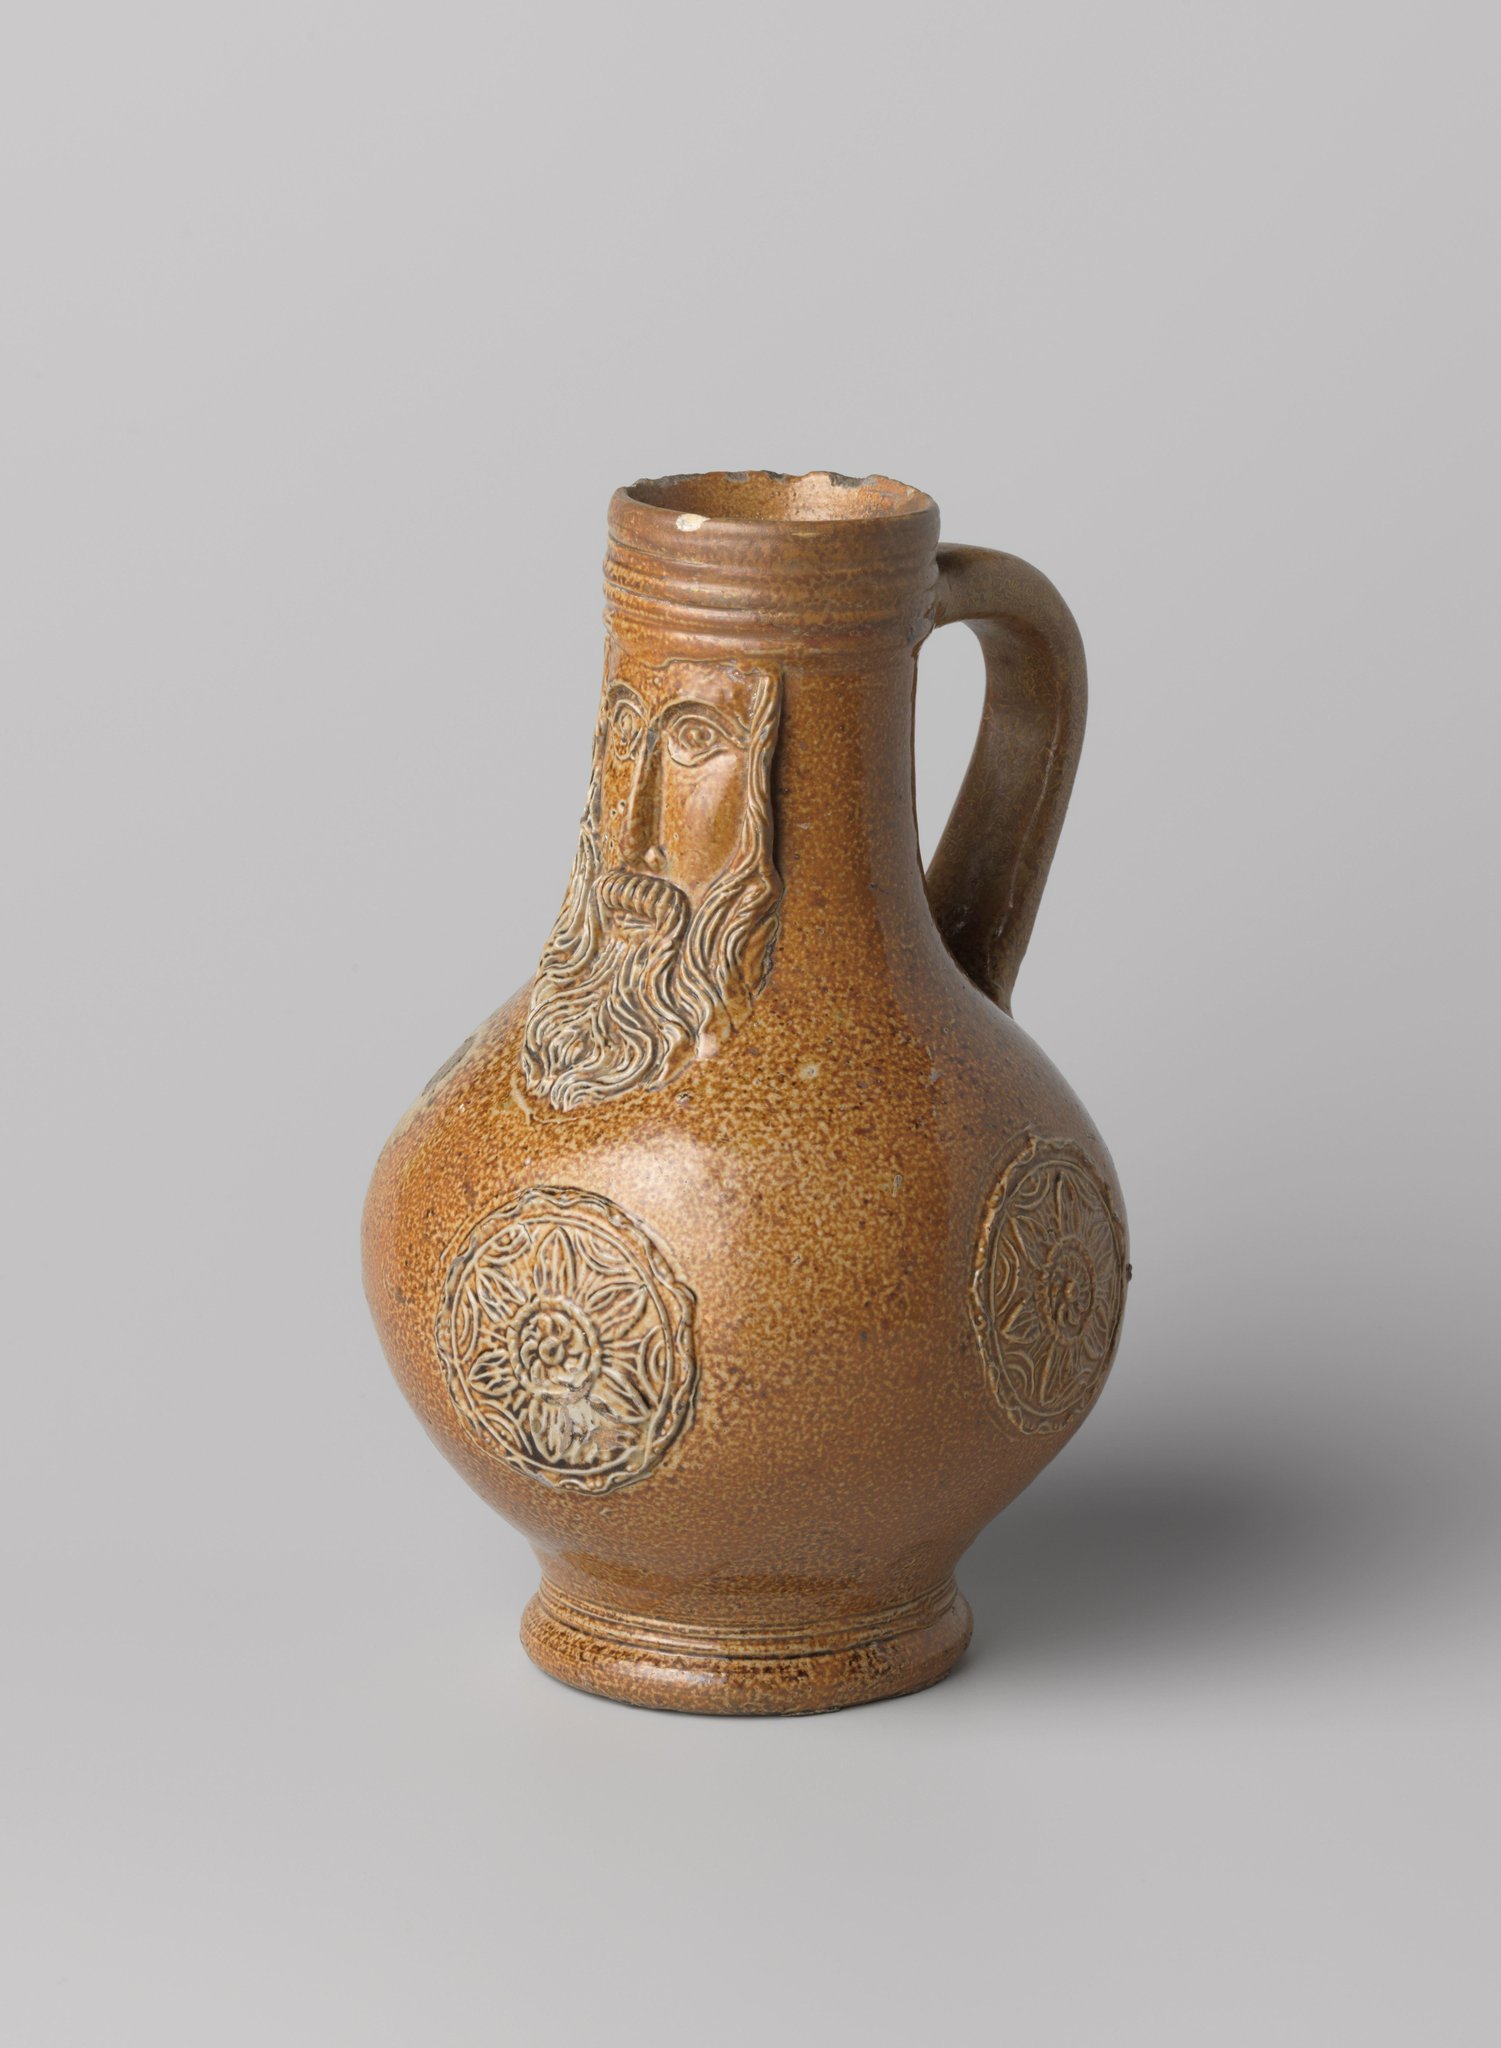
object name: jug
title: Jug (Bartmann jug) with a roundel in medallions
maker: Anonymous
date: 1580-1630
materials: engobe, glaze, stoneware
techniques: firing, forming, relief, turning, vitrification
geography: frechen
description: Kruik (baardmankruik) van steengoed op standring met een bolvormige buik en smalle nek. Het C-vormige oor is bevestigd aan de nek en de schouder. Profielen op de nek. Bedekt met een bruine engobe. In reliëf op de buik driemaal een gedrukt en opgelegd medaillon met een rozet. Op de nek, doorlopend op de schouder, een baardman. Frechen.